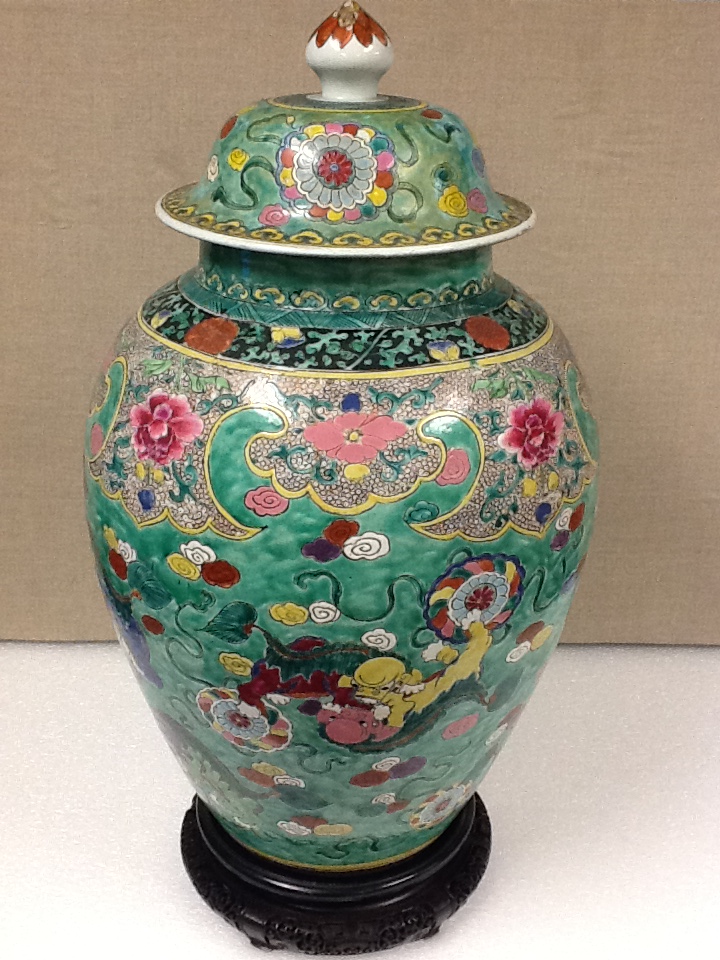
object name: covered jar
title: Covered jar with lions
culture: chinese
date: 1801-1900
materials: enamel, porcelain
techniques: overglaze, painting, polychrome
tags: lions